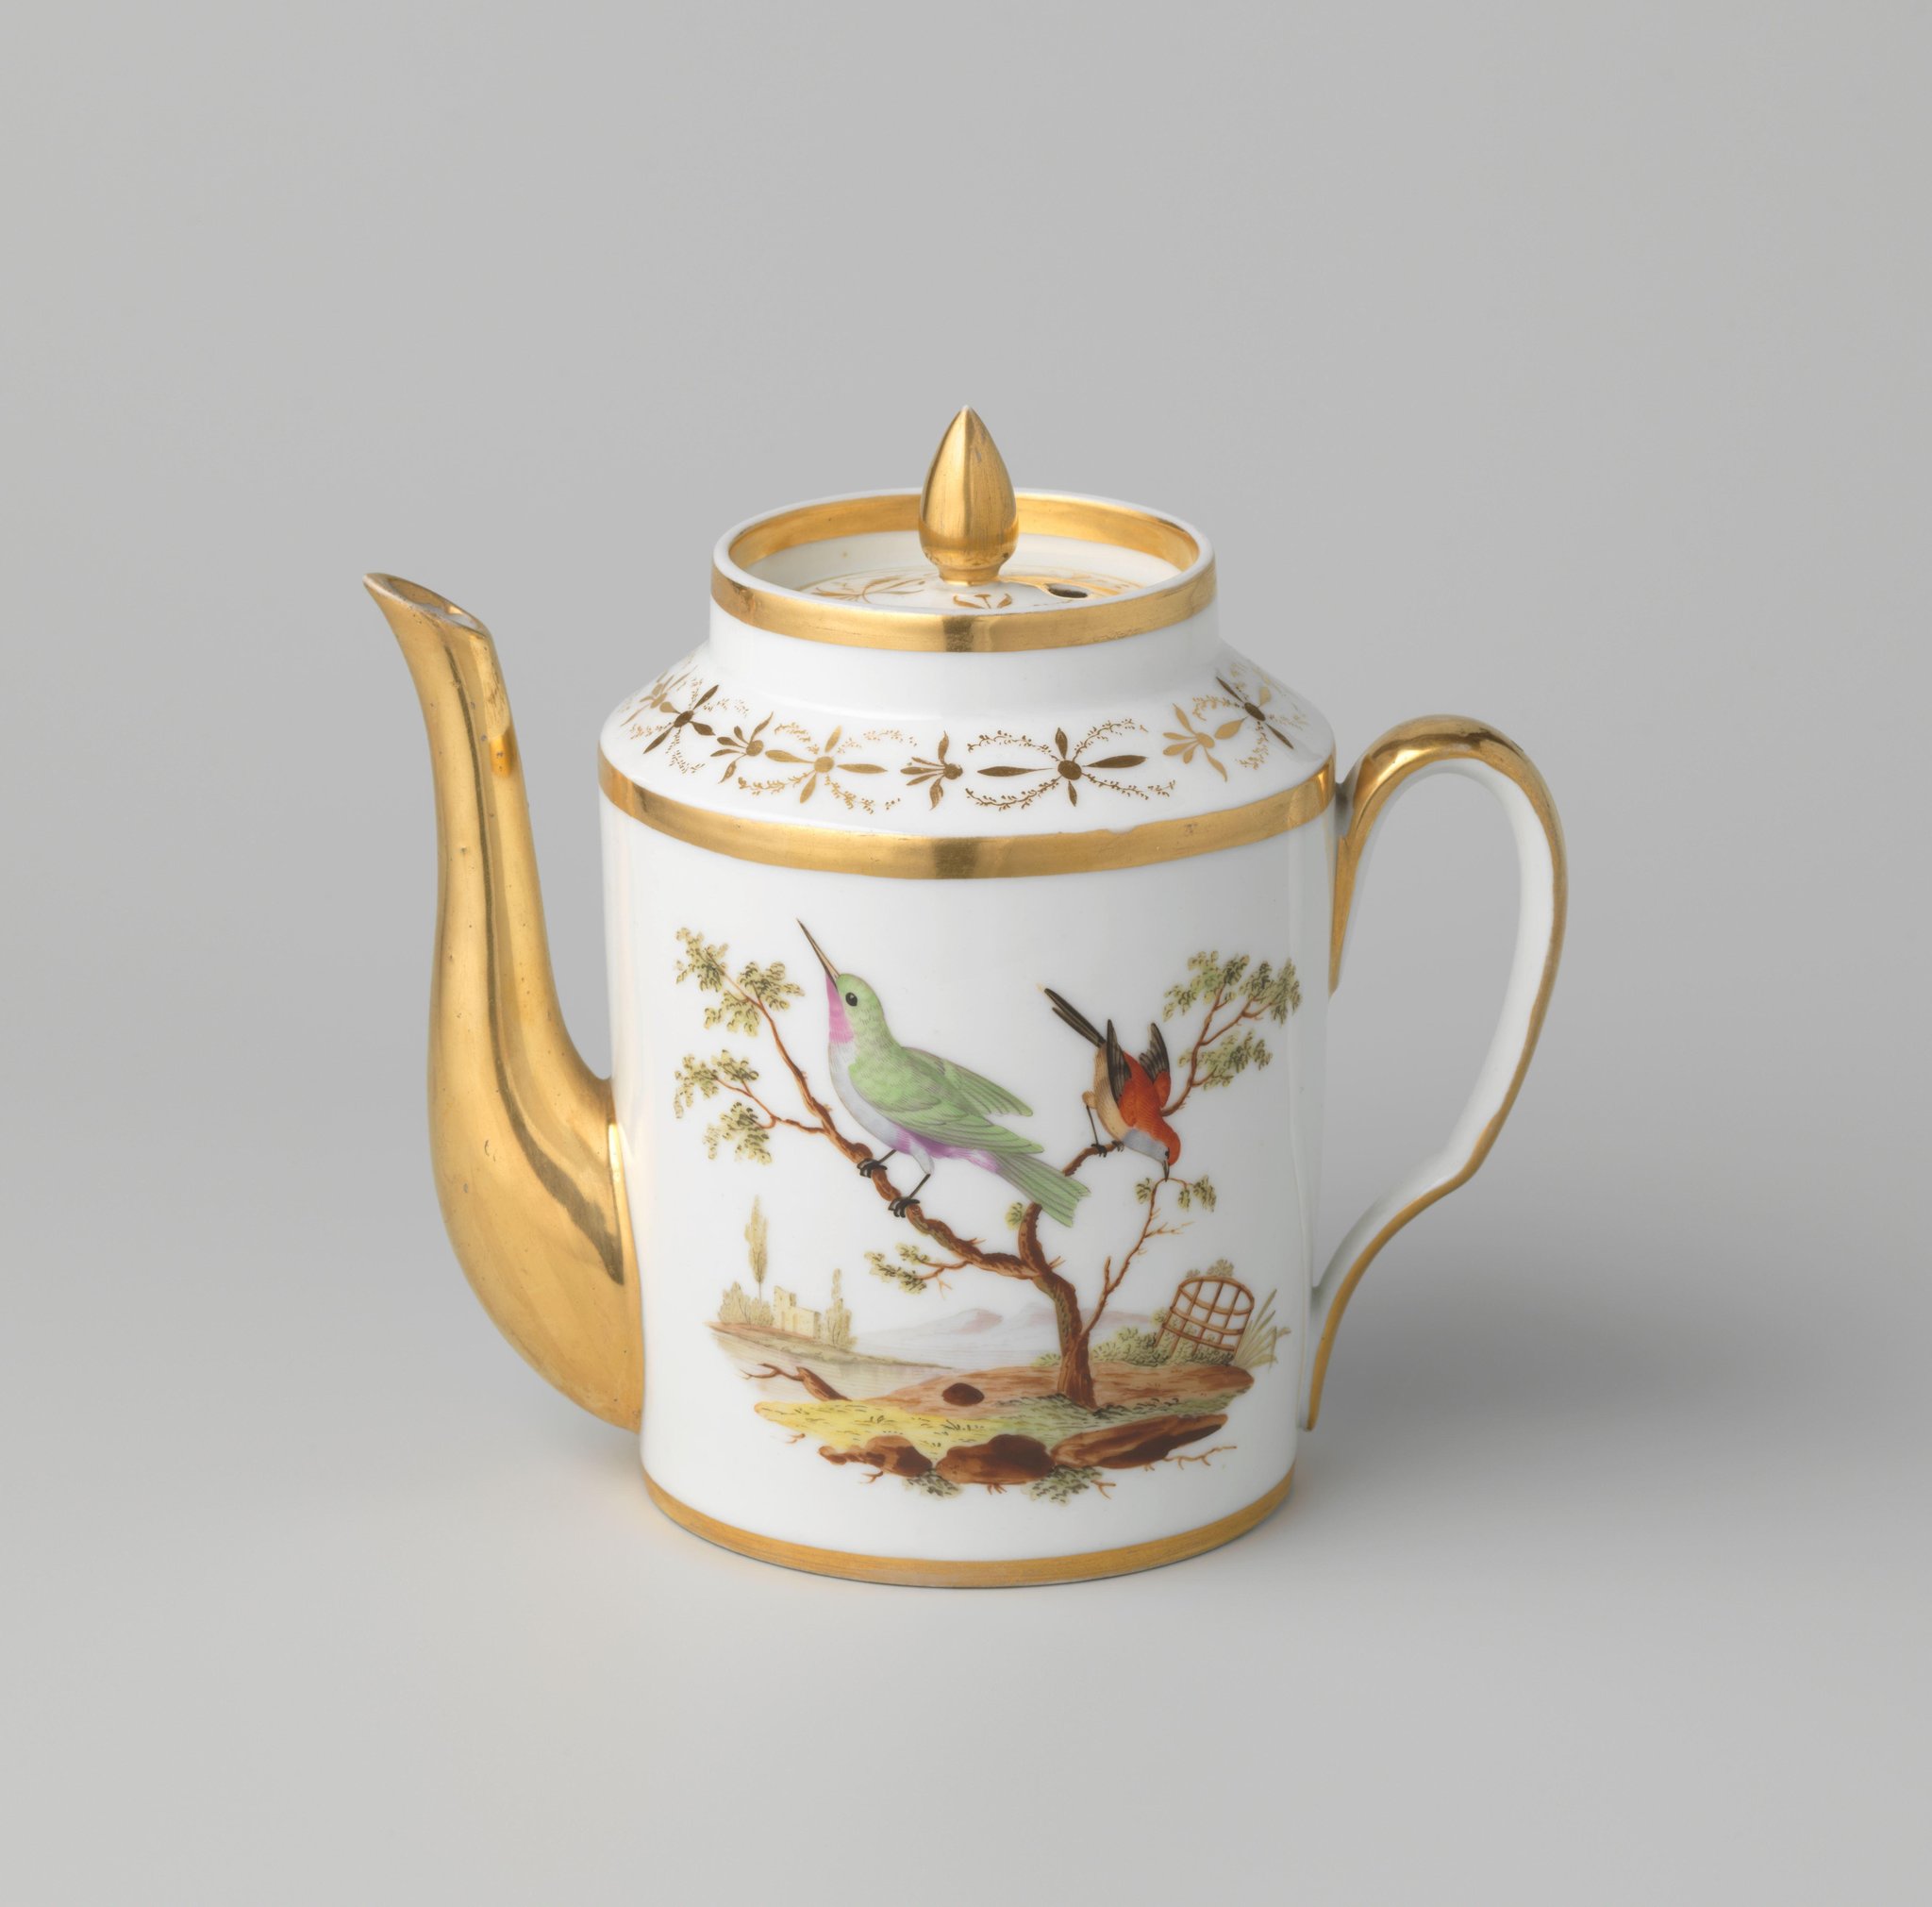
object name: teapot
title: Teapot with birds in a landscape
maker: Anonymous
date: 1790-1800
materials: glaze, gold, paint, porcelain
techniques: firing, forming, gilding, turning, vitrification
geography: france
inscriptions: mark: ‘BL’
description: Theepot van porselein met een cilindrische buik, S-vormige tuit en C-vormig oor, beschilderd op het glazuur in emailkleuren en goud. Op de buik tweemaal twee vogels op een tak in een landschap. Hierboven en -onder en op de rand een gouden band. Op de schouder bloemranken. De tuit en het oor zijn bedekt met goud. De deksel met dezelfde decoratie. Gemerkt op de onderzijde met BL.